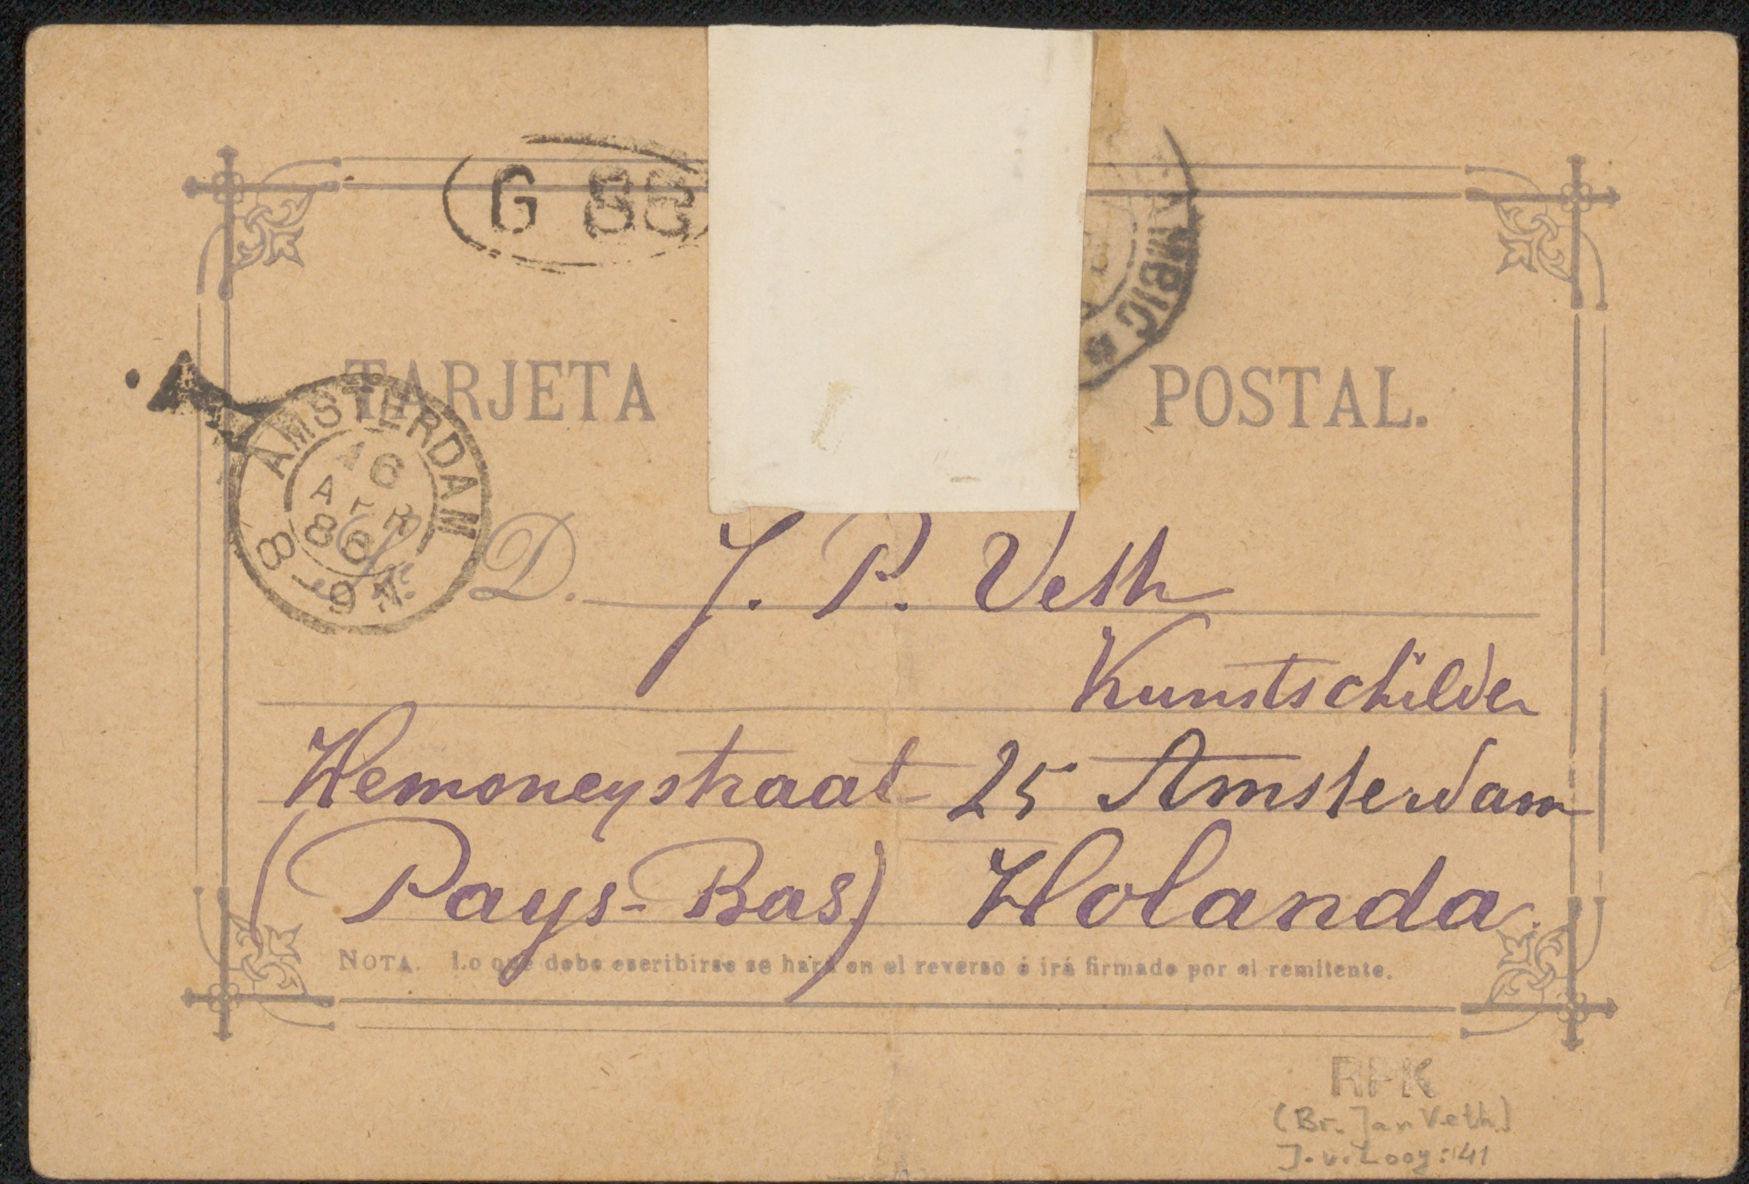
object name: postcard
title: Briefkaart aan Jan Veth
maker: jac van looij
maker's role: draughtsman, painter, print maker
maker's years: 1855-1930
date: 1886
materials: cardboard, ink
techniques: pen, writing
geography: madrid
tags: dordrecht, designer, jan veth, deventer, martha van vloten, den helder, amsterdam, jan dunselman, travelling; tourism, the hague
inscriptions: collector's mark: ‘RPK’